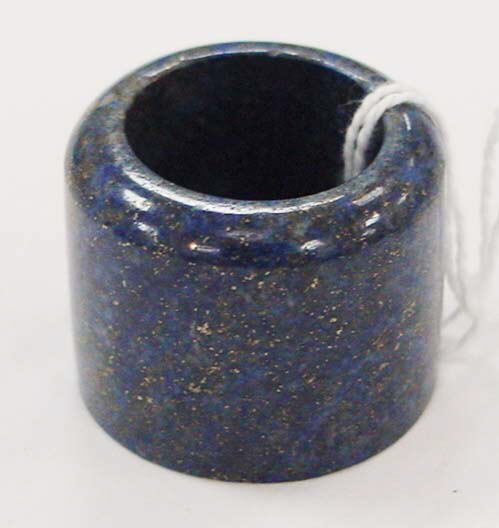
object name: ring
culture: chinese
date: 1801-1900